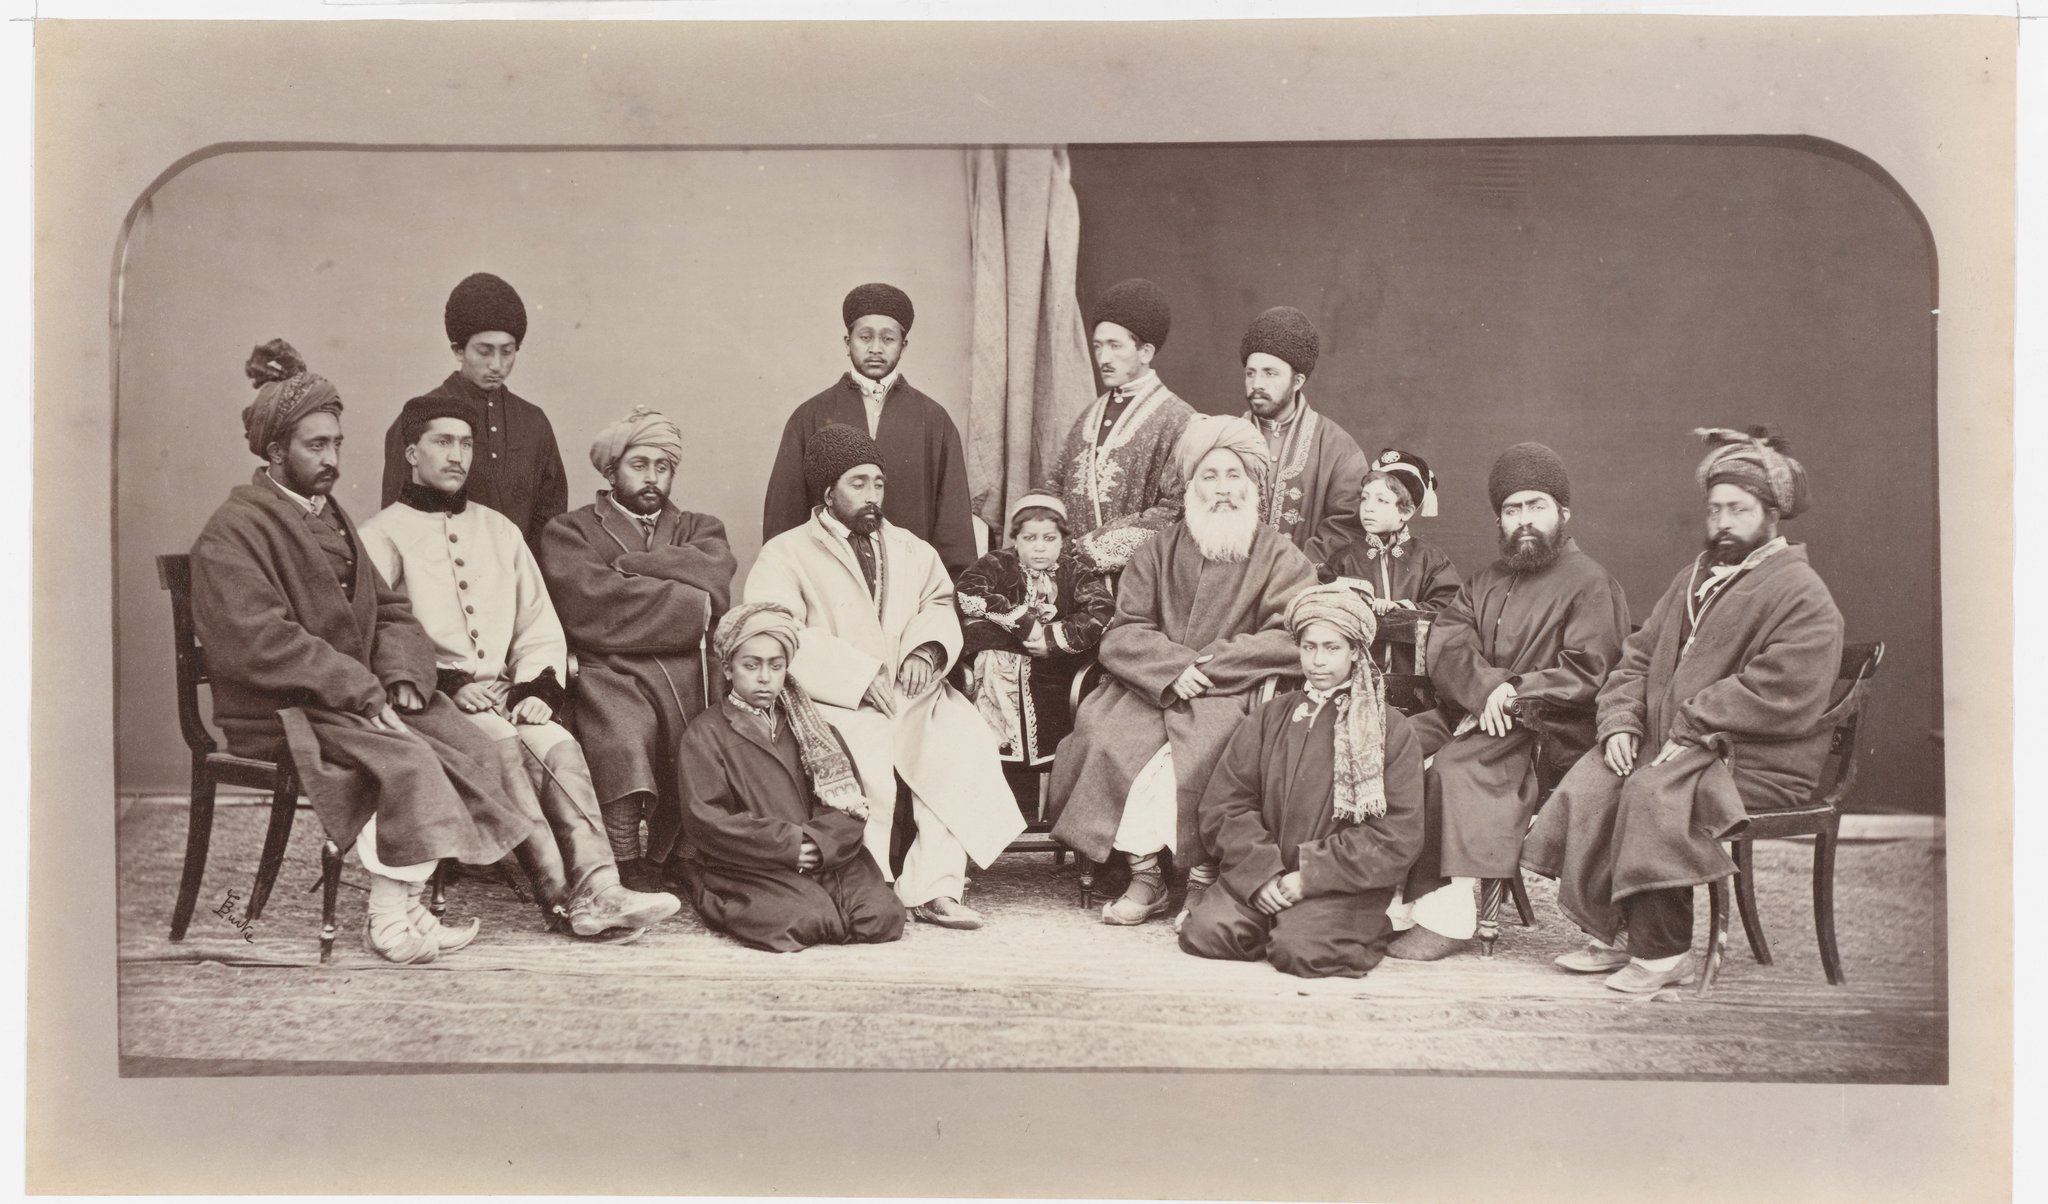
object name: photograph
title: Group portait of the family of Dost Mohammed Khan, with Sher Ali Khan and Abdur Rahman Khan, Afghanistan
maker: j.n.o. burke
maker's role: fotograaf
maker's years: 1843-1900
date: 1878-1880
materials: paper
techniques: albumen print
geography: afghanistan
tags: historical persons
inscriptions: number: ‘87’, name: ‘Burke’